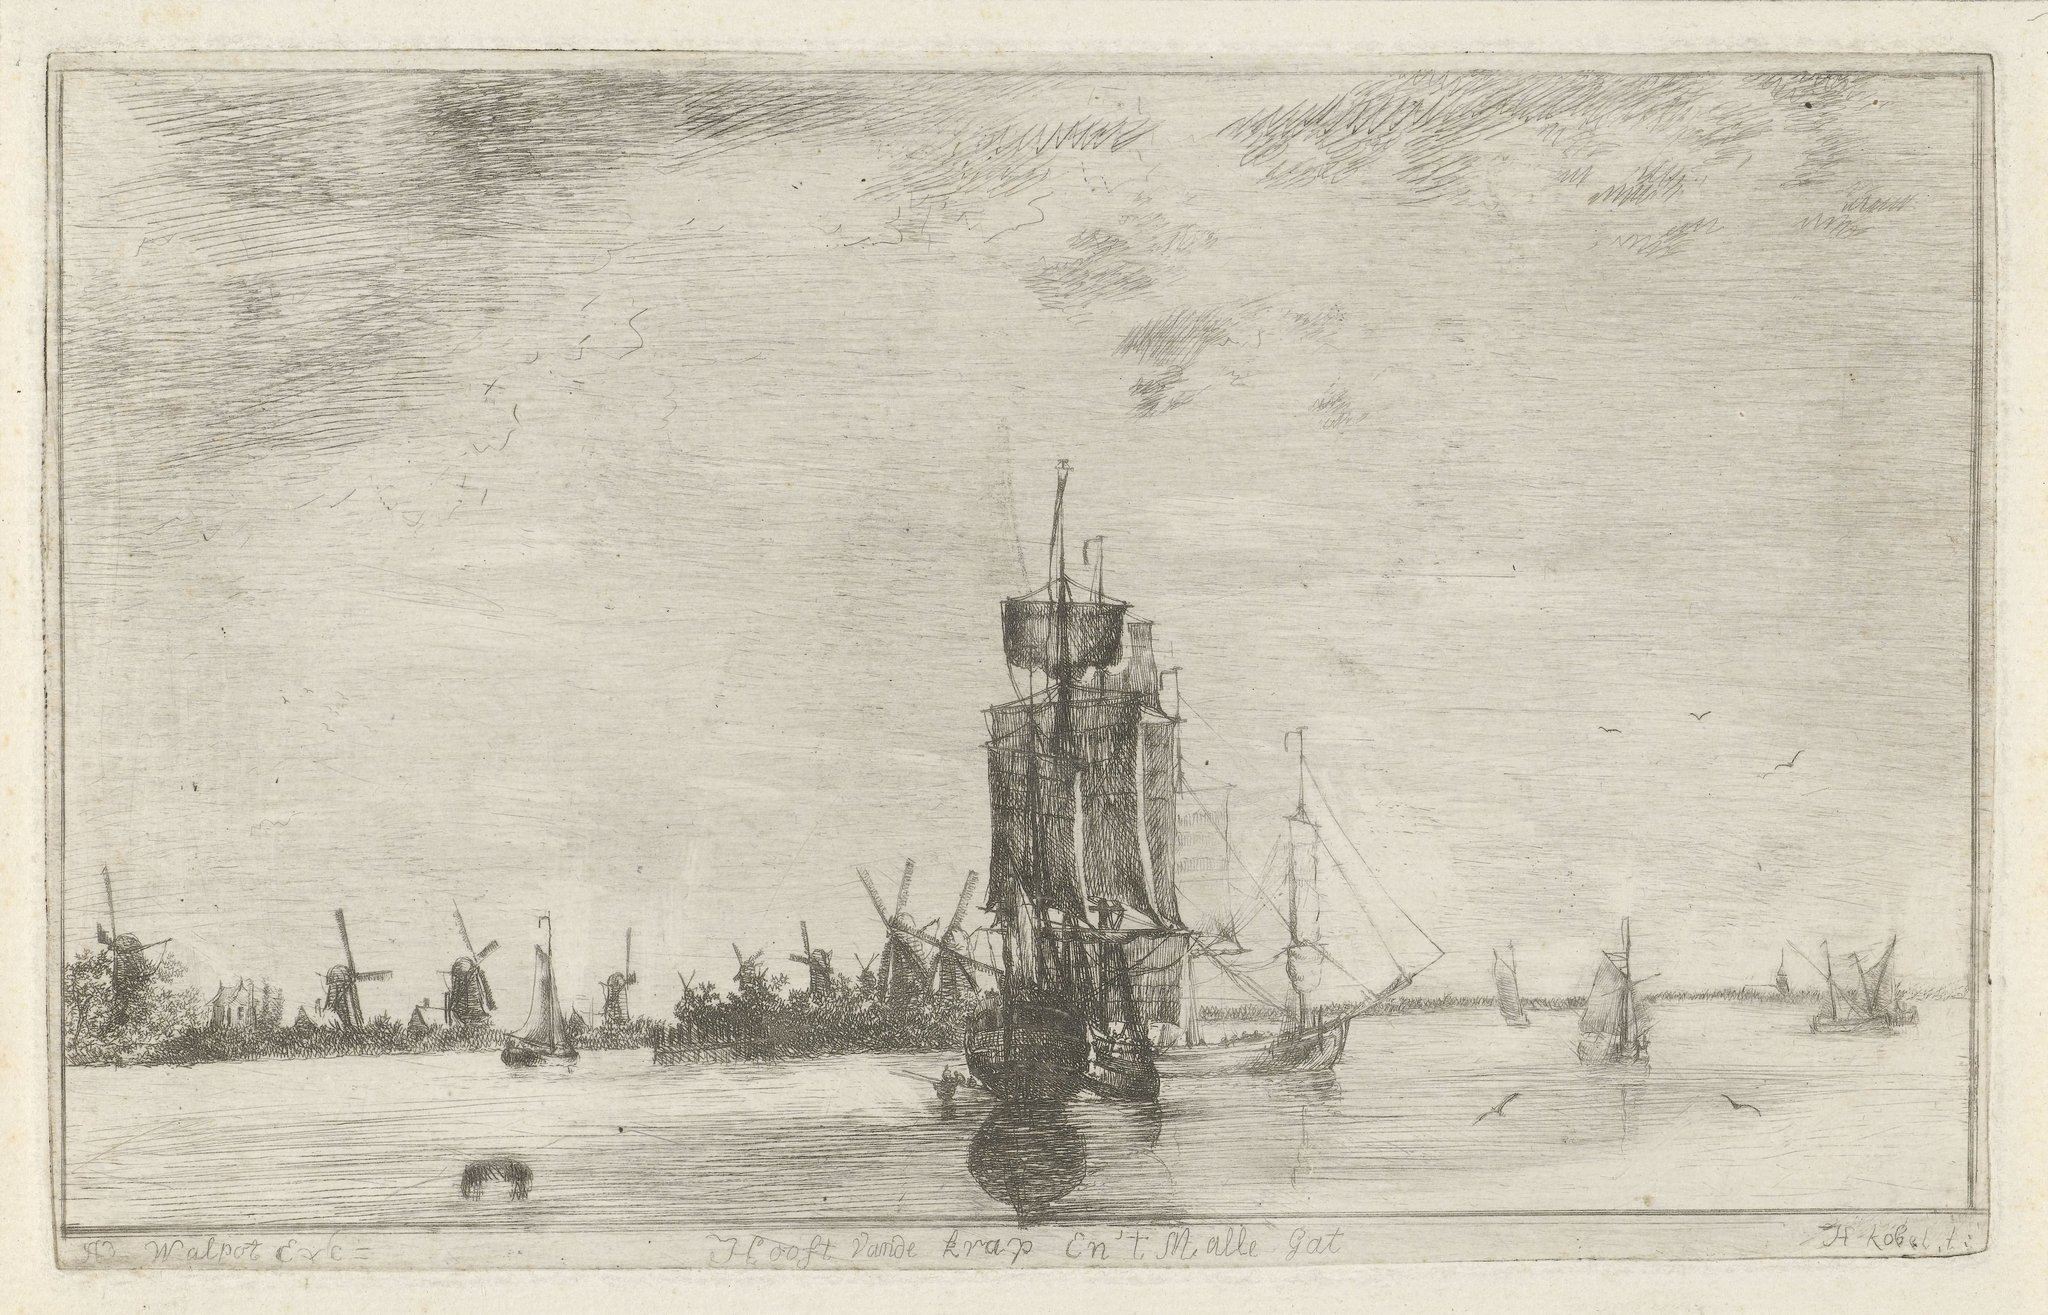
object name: print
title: Hooft Van de Krap En 't Malle Gat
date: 1762-1779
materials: paper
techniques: etching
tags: sailing-ship, sailing-boat, windmill, dordrecht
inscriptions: collector's mark: Lugt 2228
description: Gezicht op de vaargeulen Krabbegeul en Mallegat bij Dordrecht, met aan de oever enkele huizen en negen molens.